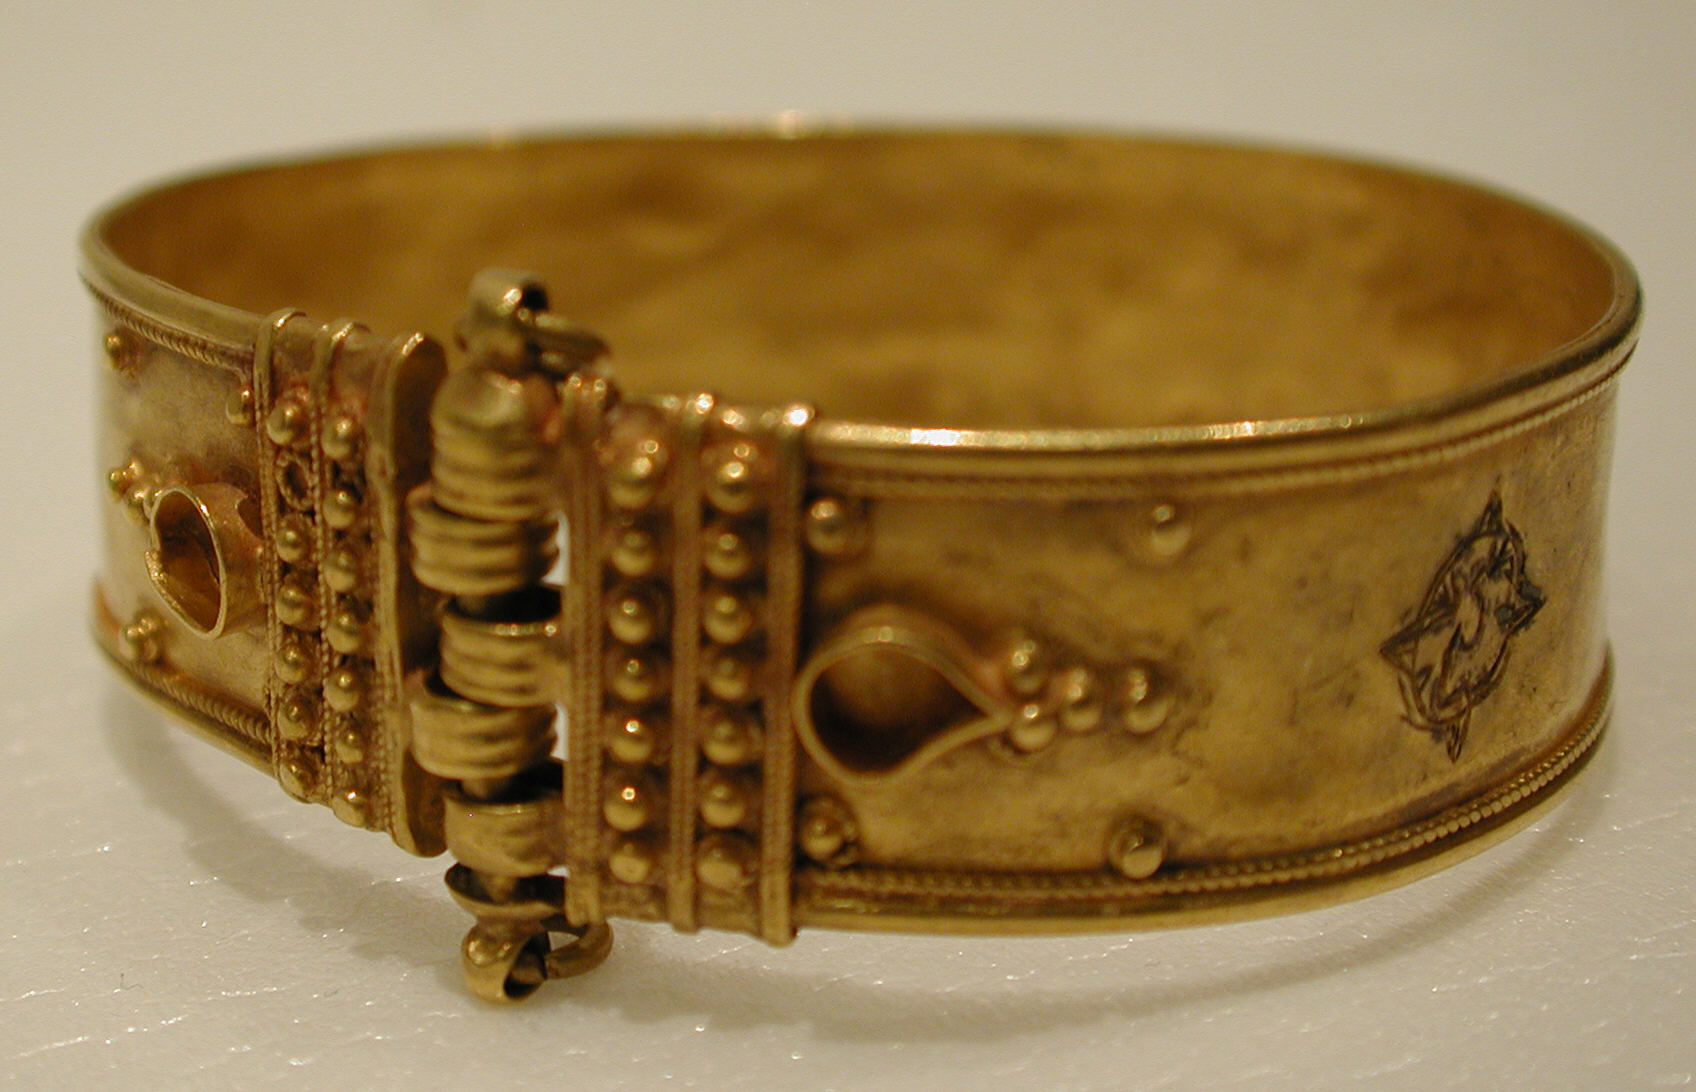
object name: bracelet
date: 1101-1300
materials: gold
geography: iran